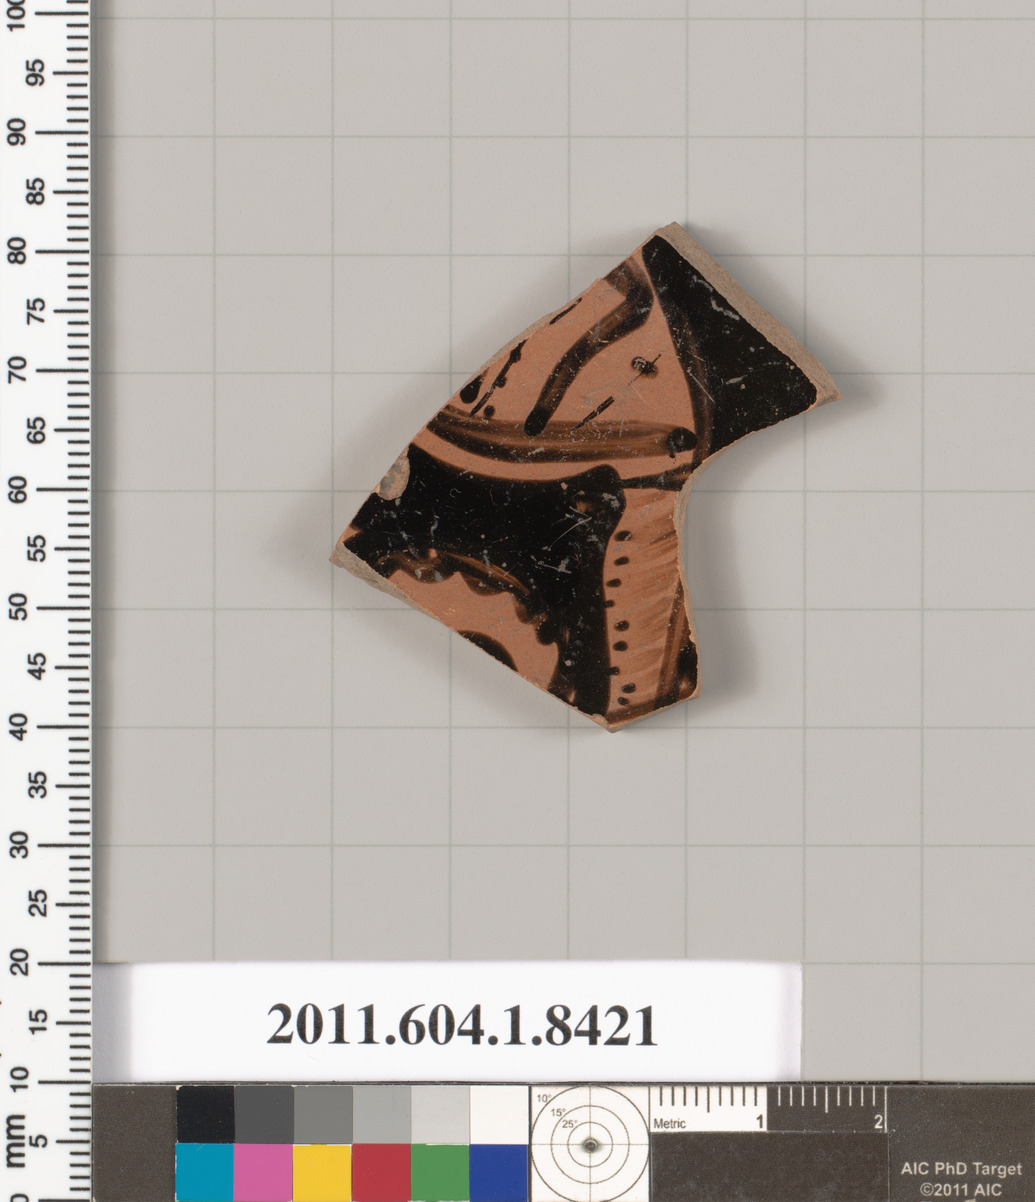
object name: kylix fragment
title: Terracotta fragment of a kylix (drinking cup)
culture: greek, attic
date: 367-335 BCE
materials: terracotta